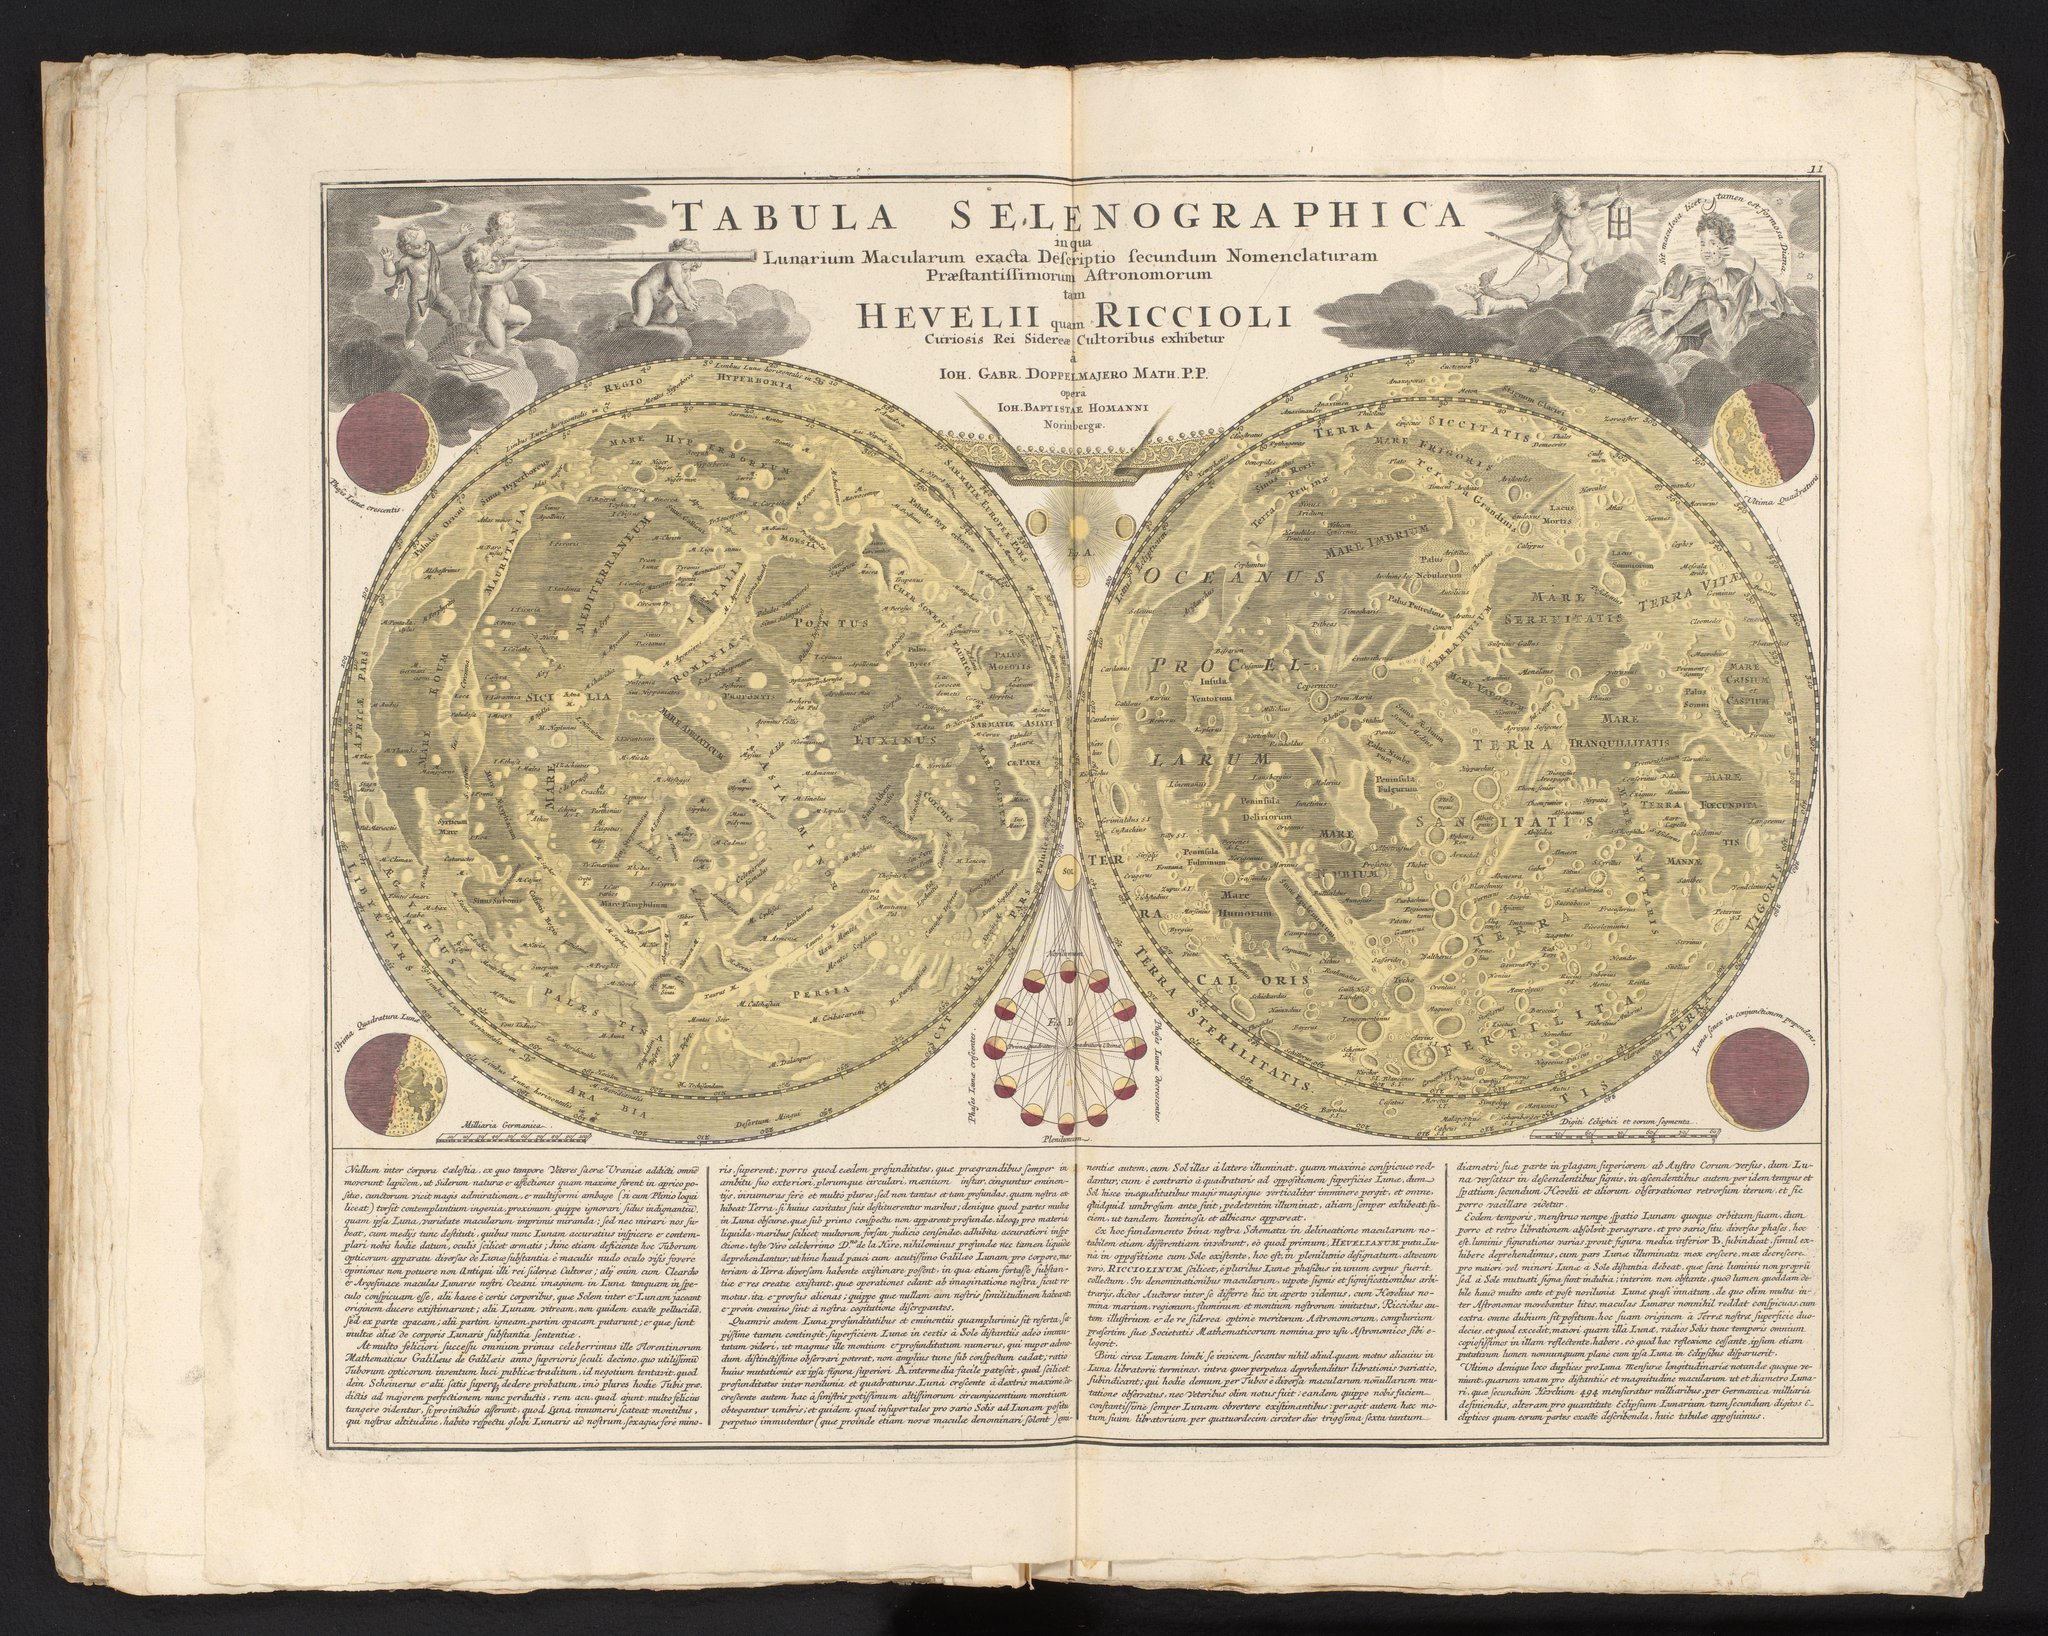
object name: print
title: Tabula selenographica in qua lunarium macularum exacta descriptio (...)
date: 1742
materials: paper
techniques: engraving, etching, hand coloring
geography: nuremberg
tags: full moon, (story of) diana (artemis), maps, atlases, telescope